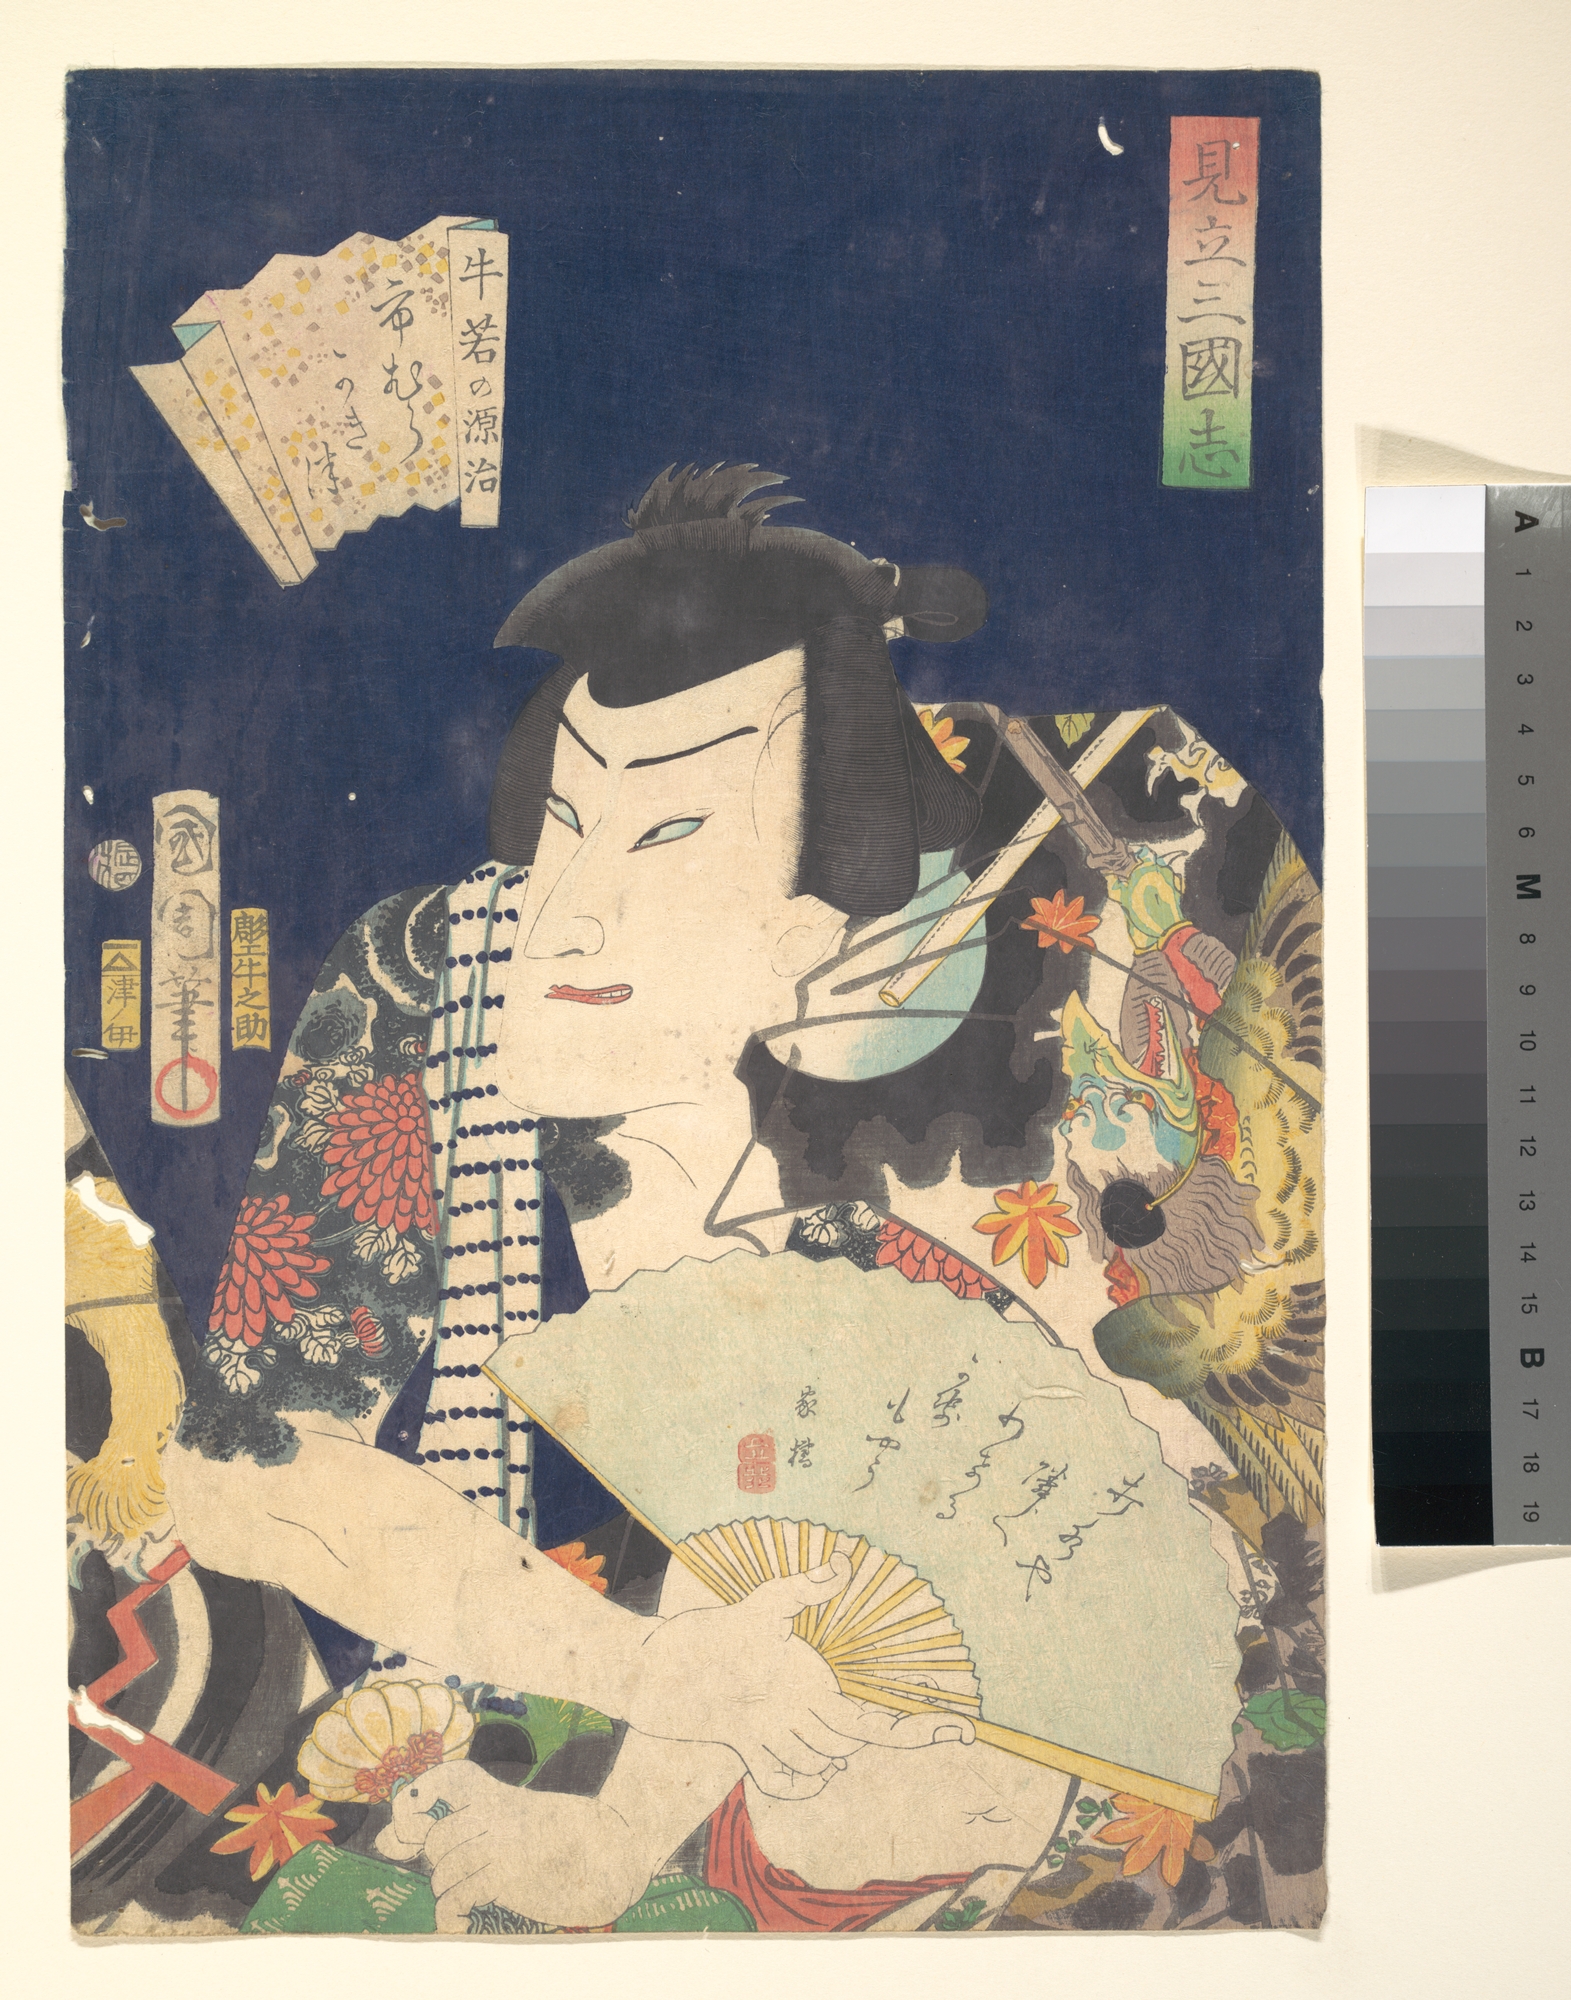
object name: print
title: Ichimura Kakitsu IV as Ushiwaka no Genji in the Kabuki play A Parody of the Romance of the Three Kingdoms (Mitate Sangokushi-Ushiwaka no Genji)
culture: japanese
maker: toyohara kunichika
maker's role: artist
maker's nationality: japanese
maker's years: 1835-1900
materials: ink, paper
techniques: woodblock print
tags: fans,men,actors